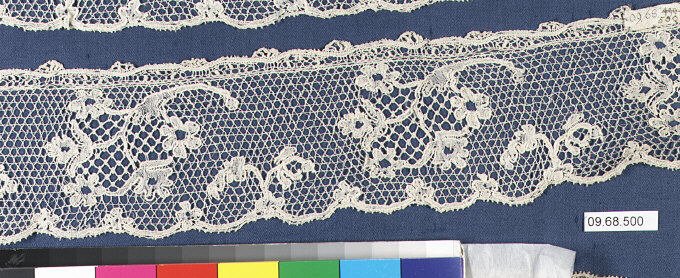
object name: fragment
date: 1801-1900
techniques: lace